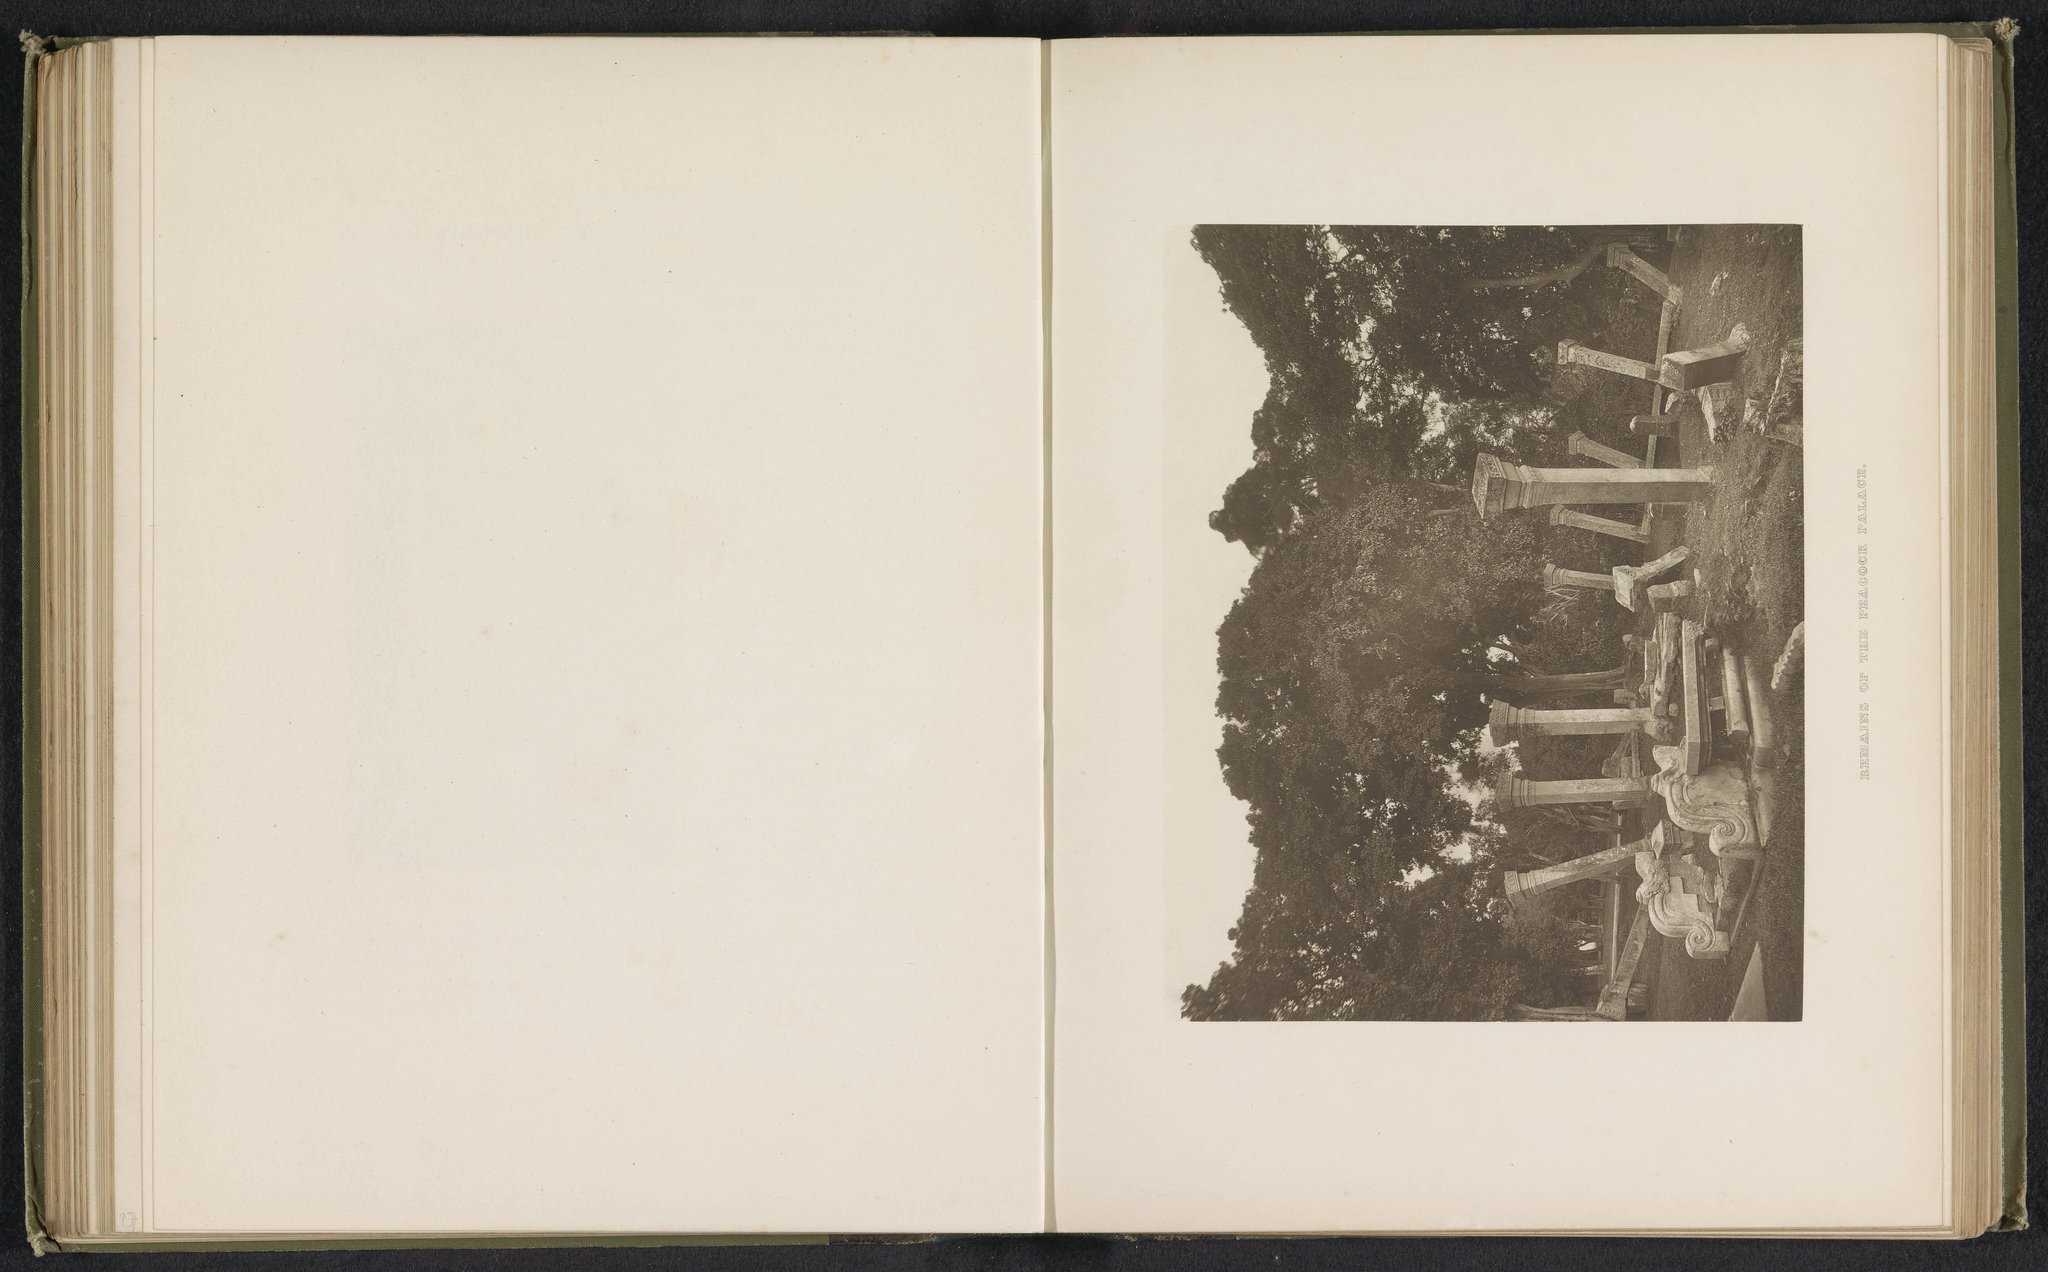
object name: photomechanical print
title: Ruins of the Mayura Pirivena monastic complex at Anuradhapura, Sri Lanka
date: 1896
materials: paper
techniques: woodburygravure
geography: anuradhapura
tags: column, pillar ~ architecture, ruin of a dwelling, house, castle, etc.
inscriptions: title: ‘REMAINS OF THE PEACOCK PALACE.’